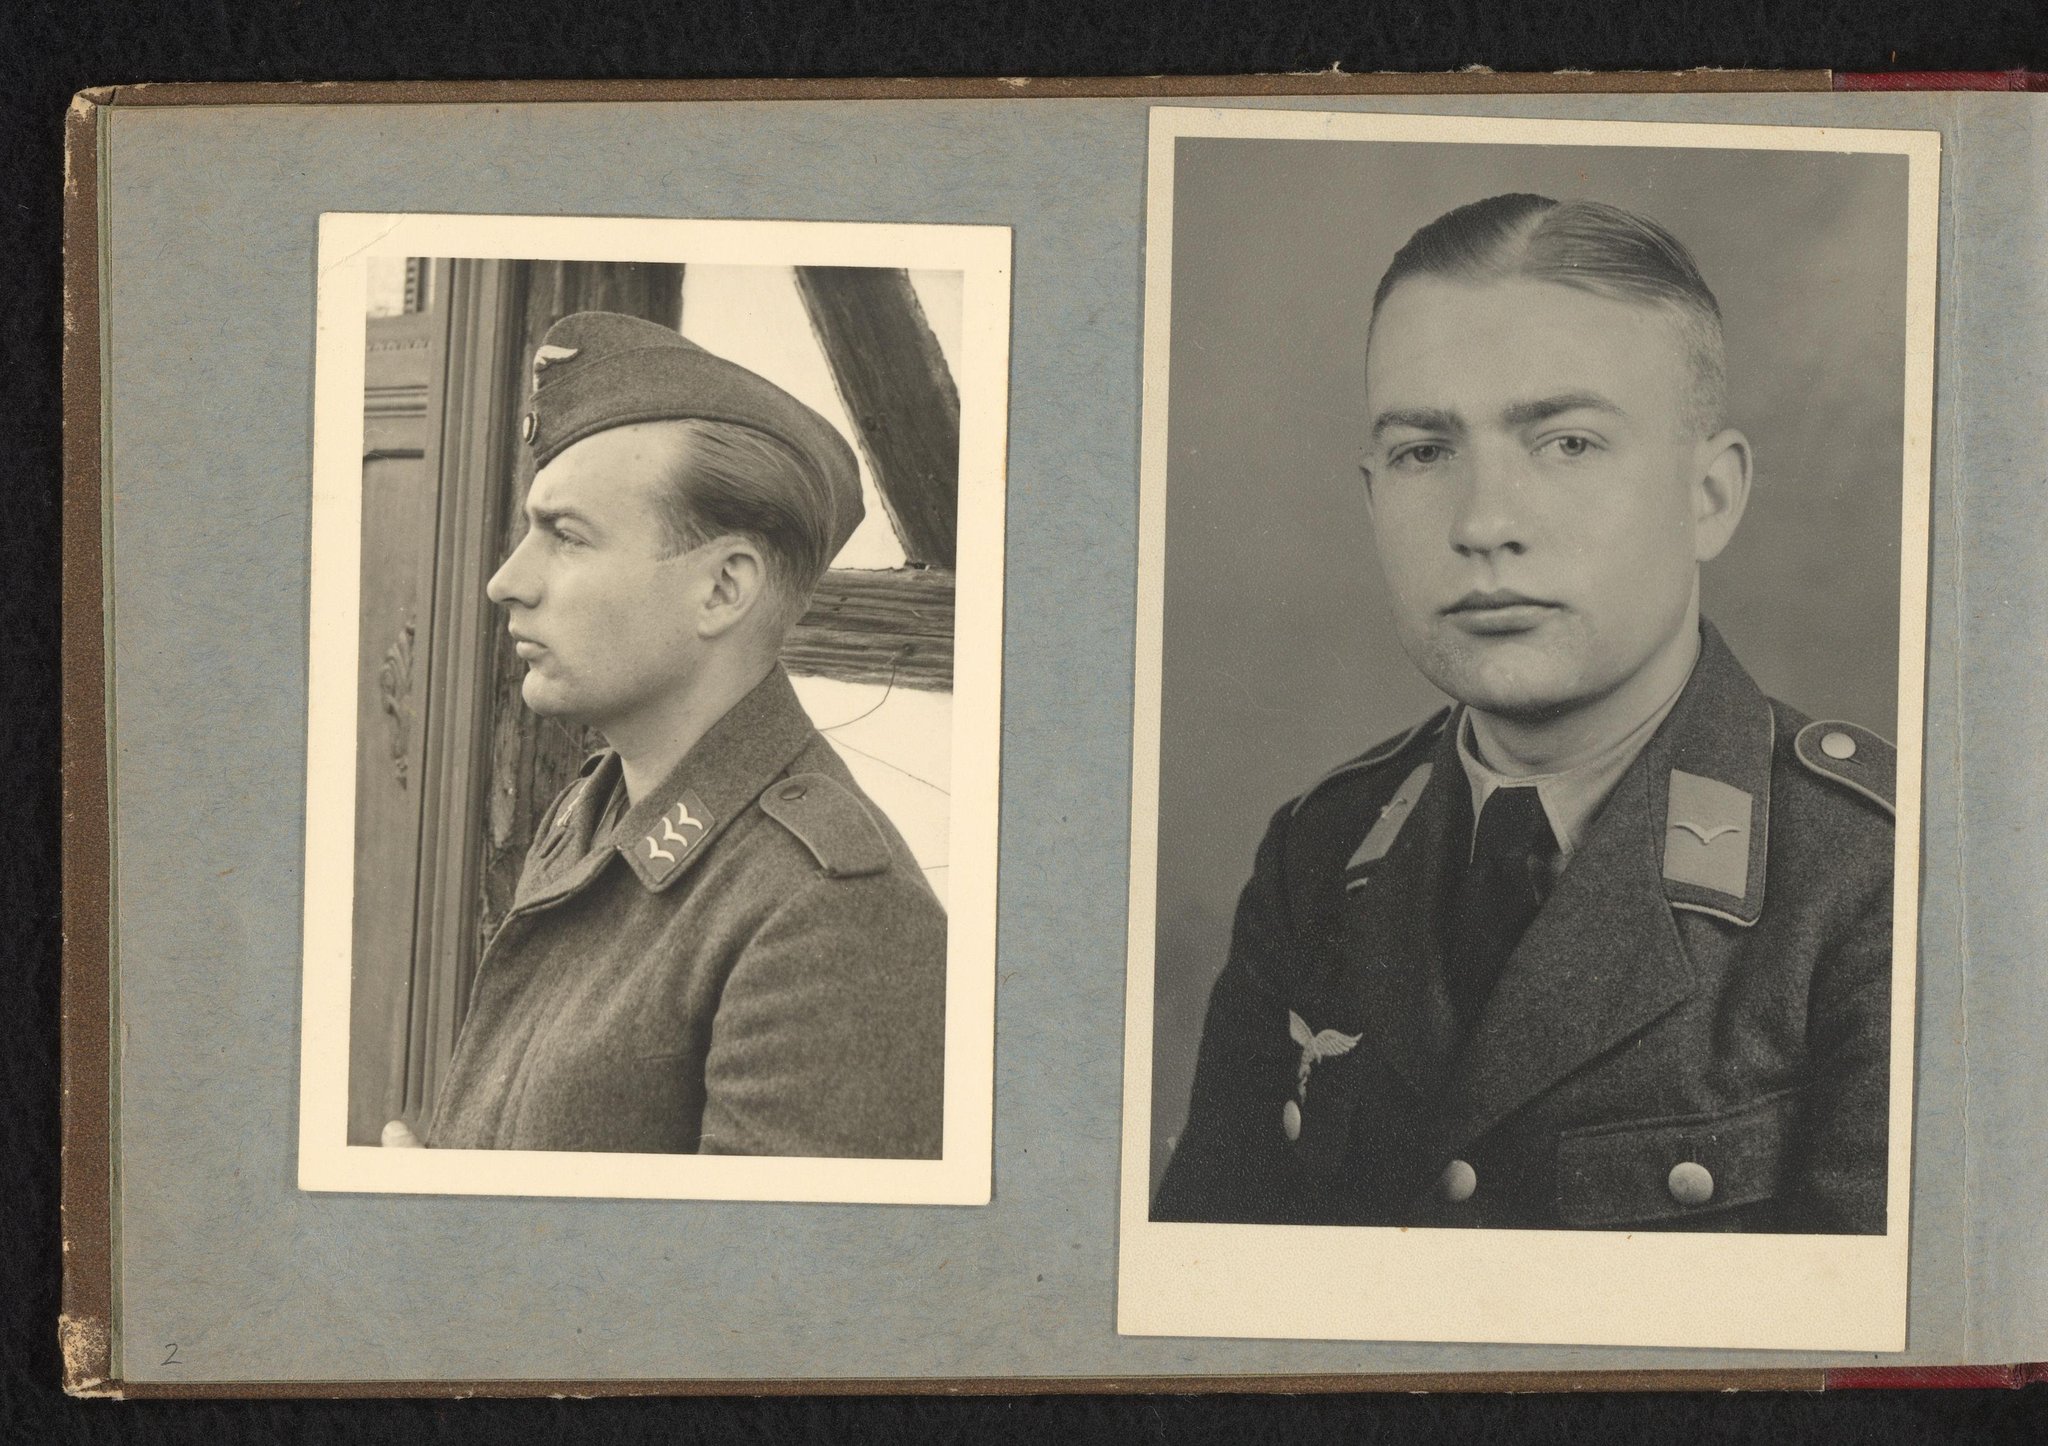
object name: photograph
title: Portretten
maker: Anonymous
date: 1940-1945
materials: paper, photographic support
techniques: gelatin silver print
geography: germany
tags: historical persons, the soldier; the soldier's life, germany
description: Albumblad met twee foto's, portretten van een Duitse militair, waarschijnlijk de samensteller van het album, Dieter Glitsch. Onderdeel van een fotoalbum over de diensttijd van Dieter Glitsch uit Hardegsen tijdens de Tweede Wereldoorlog en de jaren daarna.